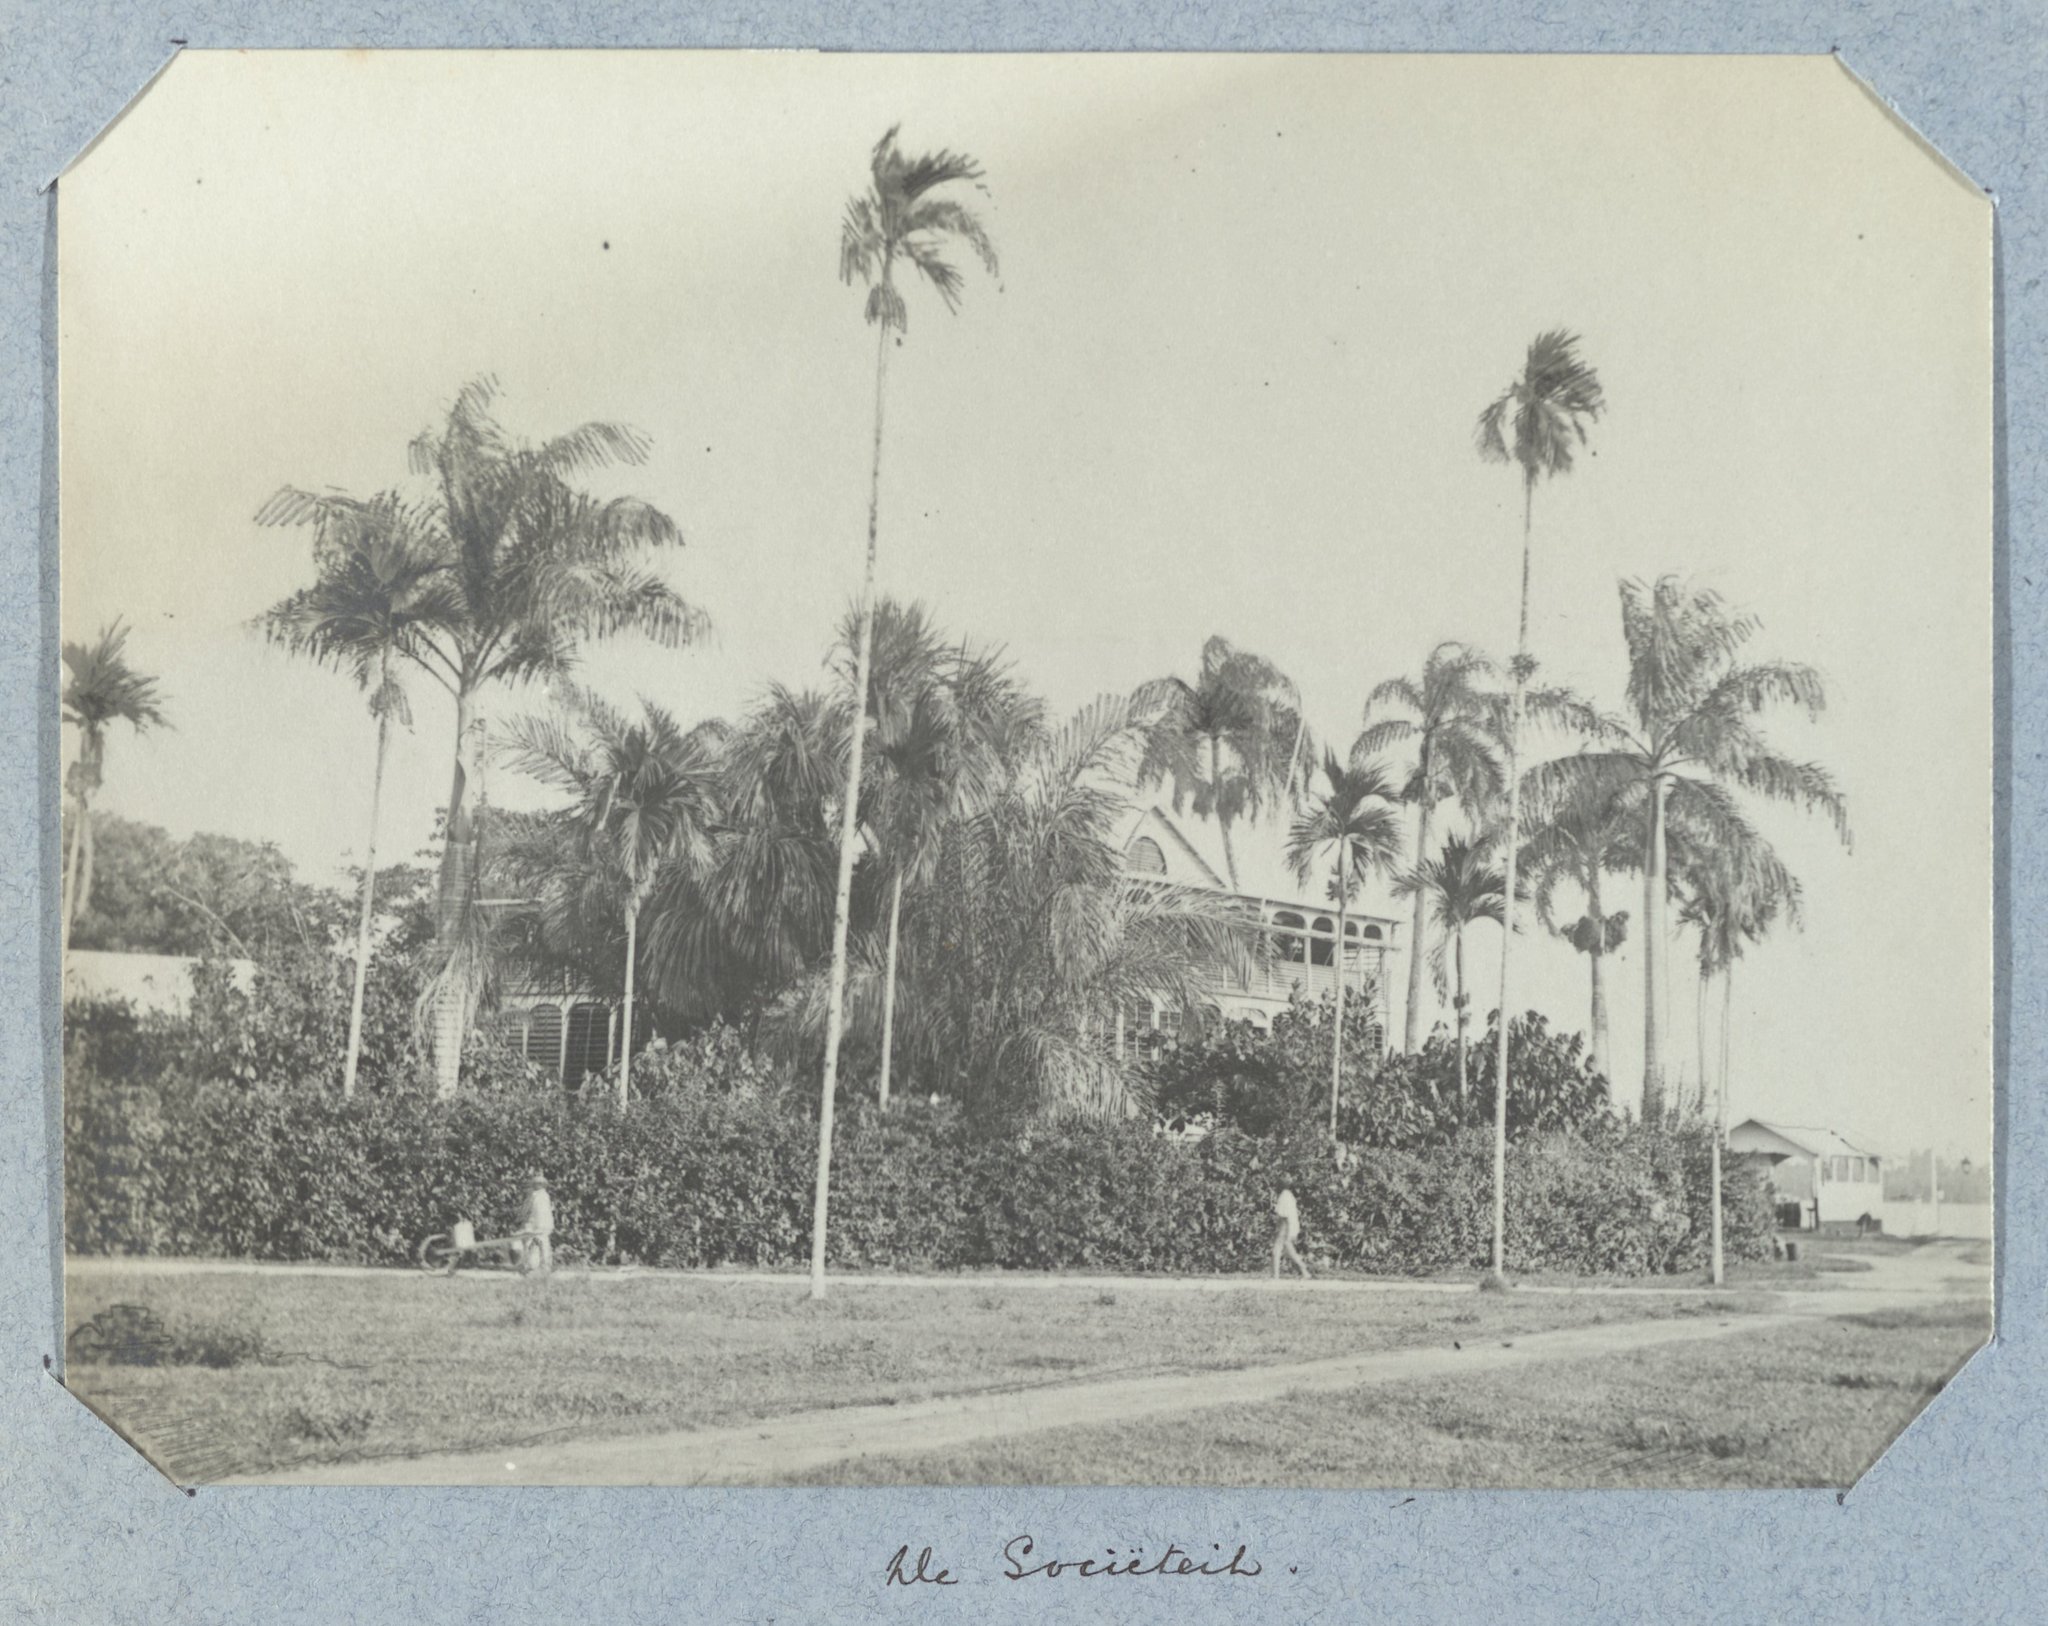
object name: photograph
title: De Sociëteit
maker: théodore van lelyveld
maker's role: painter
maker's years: 1867-1954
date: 1895-1898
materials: photographic support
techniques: gelatin silver print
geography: suriname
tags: club, meeting place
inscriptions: inscription: ‘De Sociëteit.’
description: Sociëteit Het Park te Paramaribo. Fotoafdruk in een fotoalbum van Théodore van Lelyveld over Suriname uit 1895-1898.